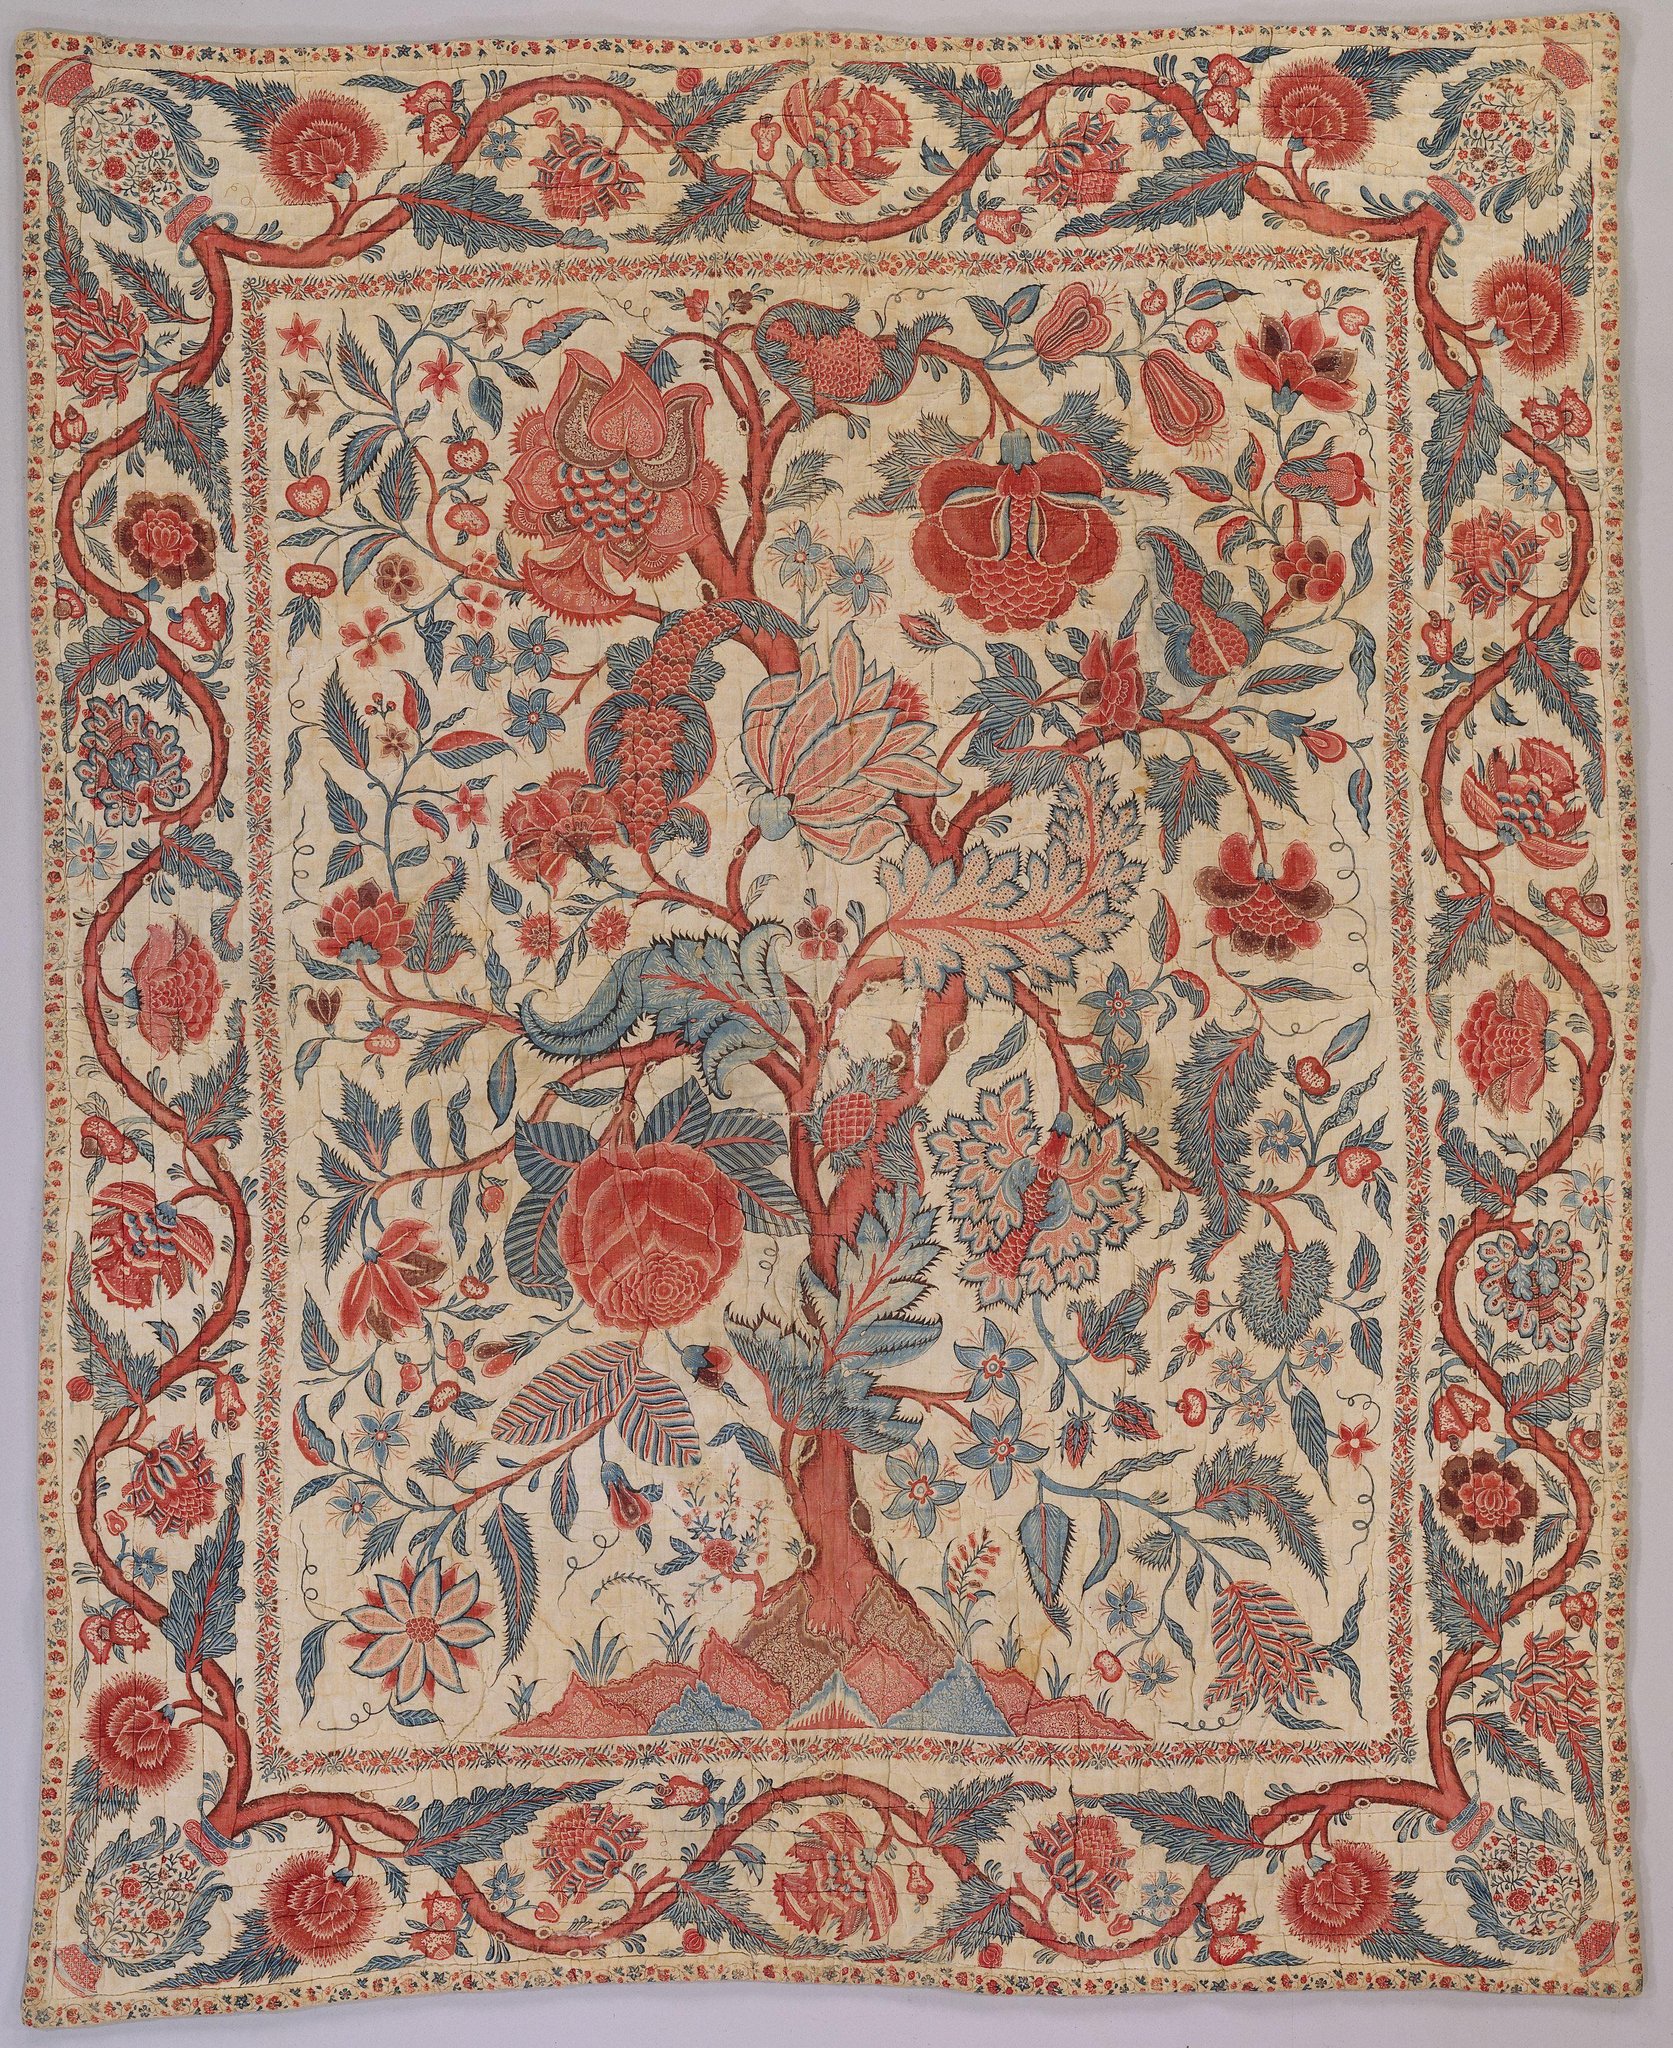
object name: bedspread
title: Een bedsprei van sits, met boommotief op wit fond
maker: Anonymous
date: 1700-1725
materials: textile, cotton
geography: coromandel coast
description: Een bedsprei van sits, met patroon van een bloeiende boom in de vorm van een stam op heuvel waaraan enkele takken met grote bloemen en bladeren. Hieromheen een brede rand, gedecoreerd met golvende bloemtakken die in de vier hoeken samenkomen in vazen.